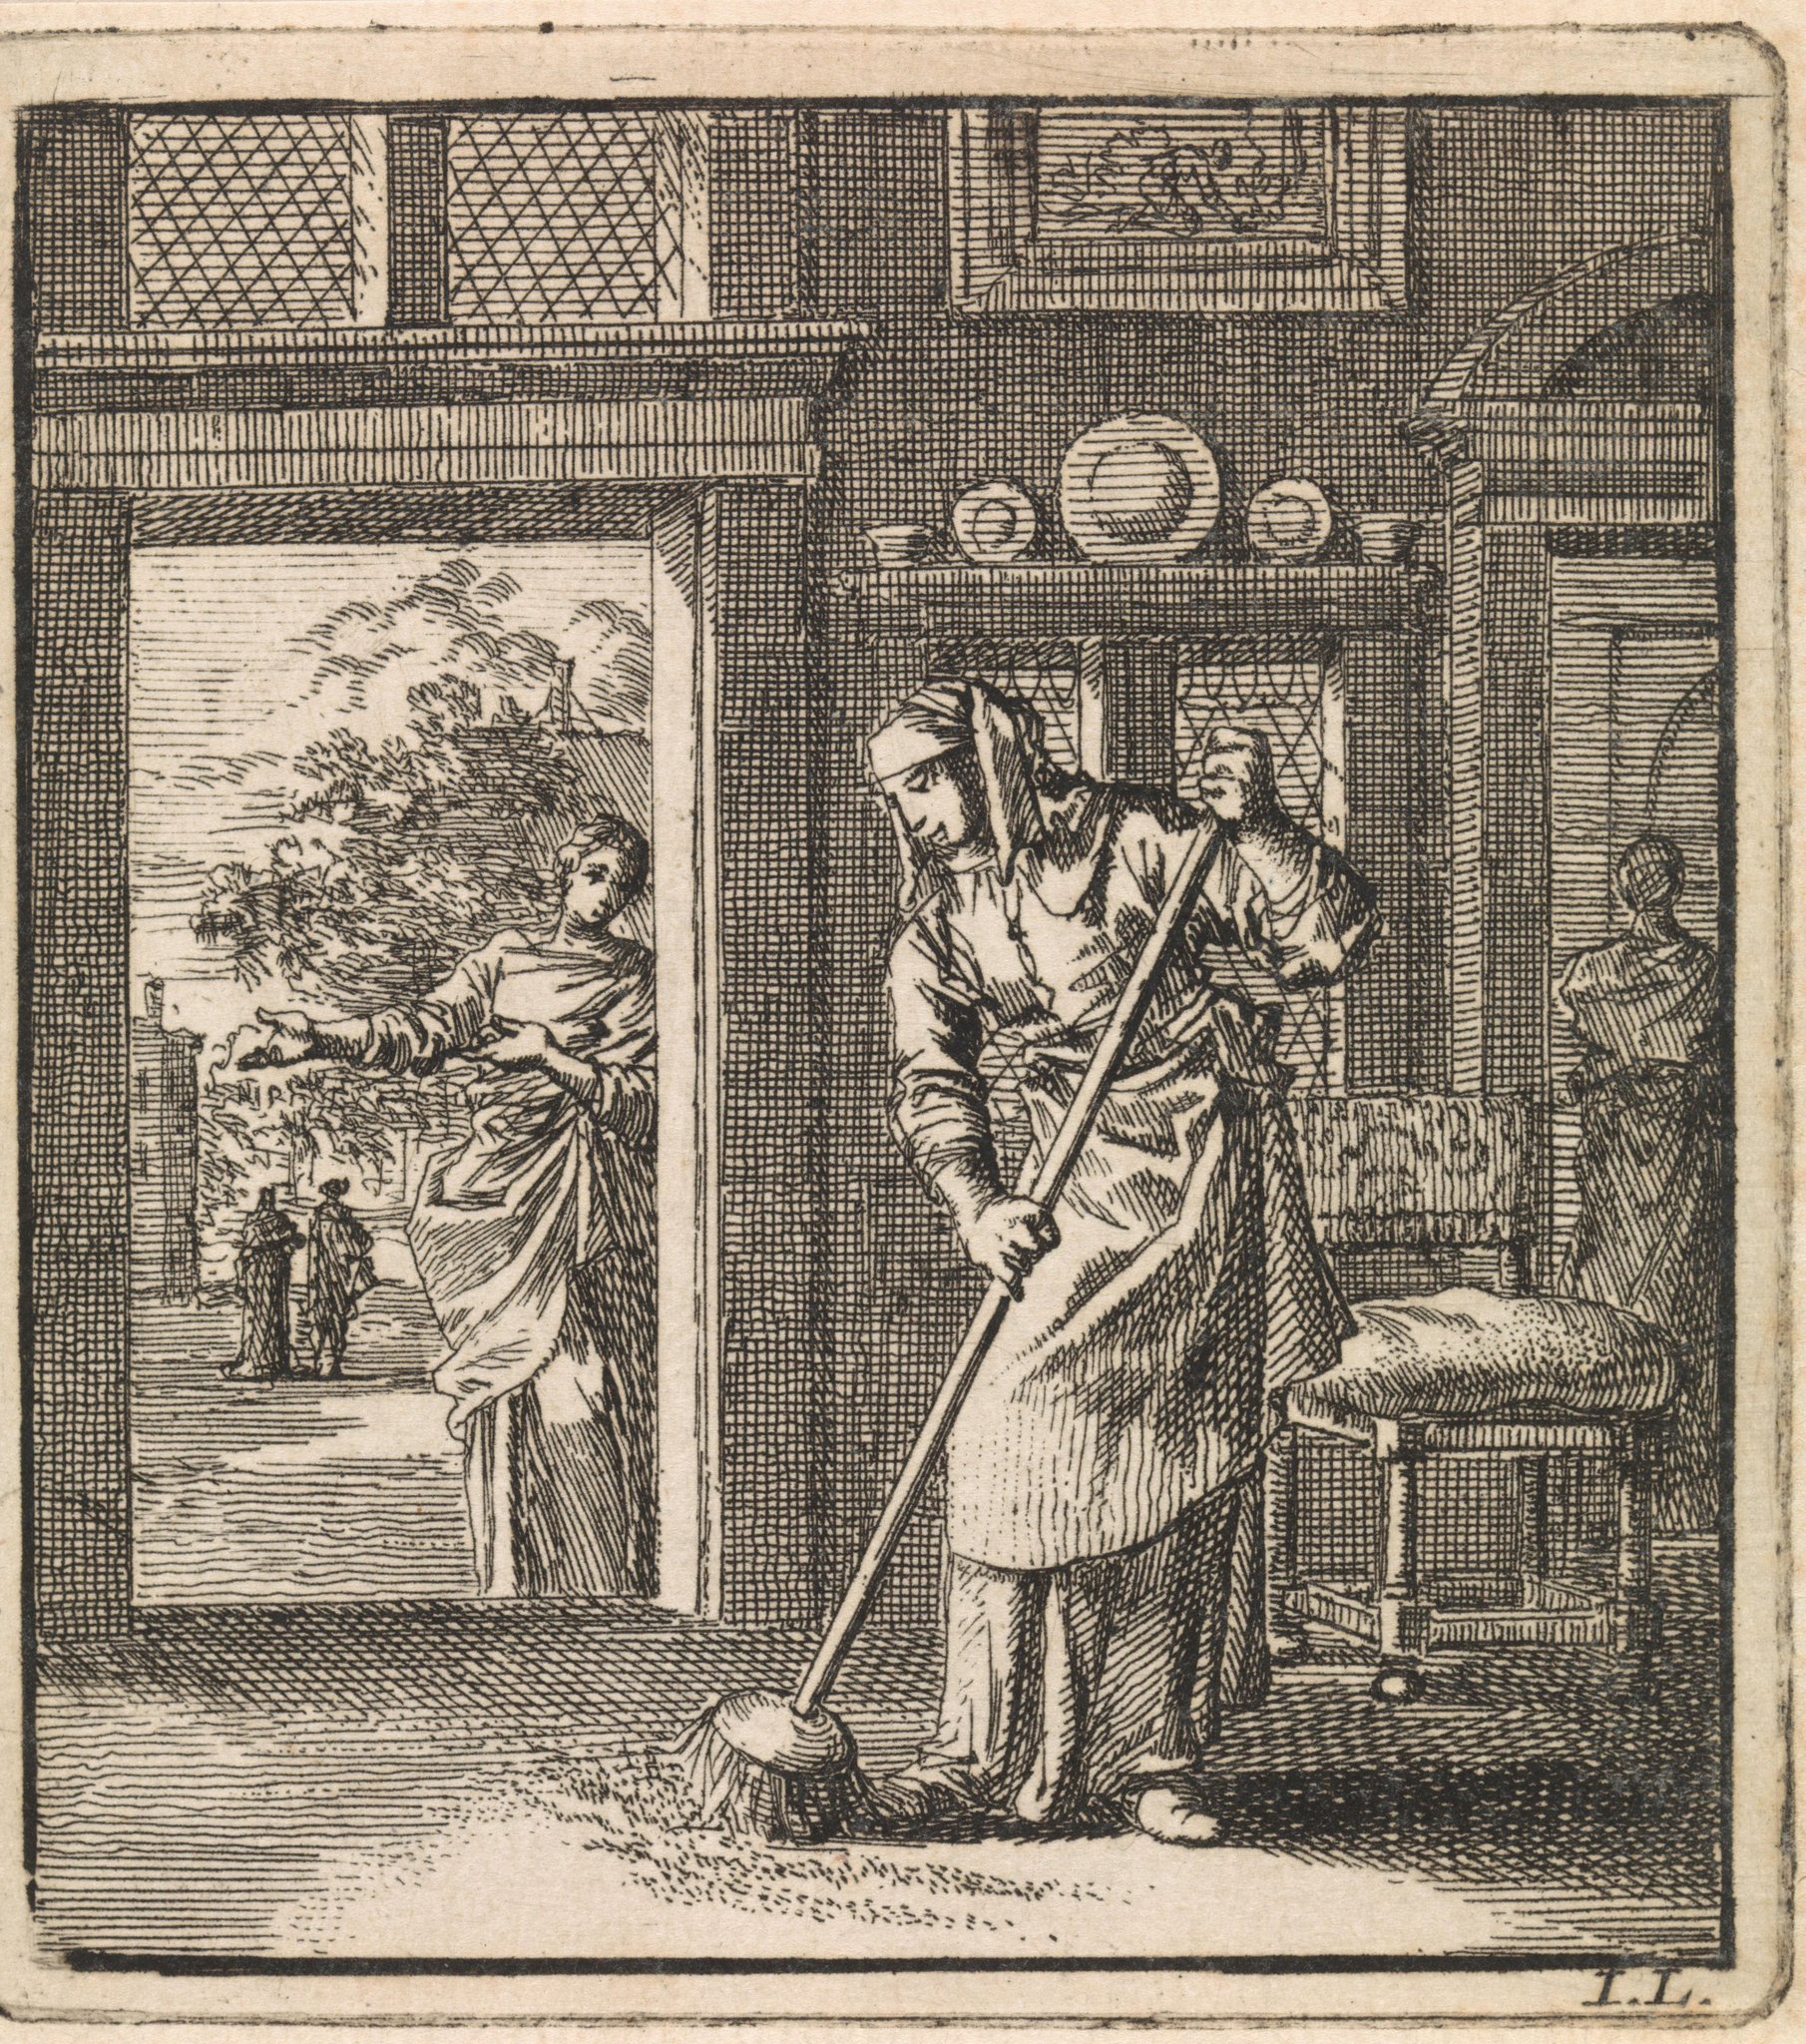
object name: book illustration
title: Vrouw veegt de vloer van een woning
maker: jan luyken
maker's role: draughtsman, print maker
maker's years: 1649-1712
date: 1711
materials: paper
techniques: etching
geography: amsterdam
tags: shrubs: broom, sweeping (~ cleaning the house)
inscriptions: collector's mark: Lugt 2228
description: Illustratie voor: Luyken, Jan. Het leerzaam huisraad, vertoond in vyftig konstige figuuren, met godlyke spreuken en stichtelyke verzen: Pieter Arentsz. II (wed.) en Cornelis van der Sys, 1711, p. 146.